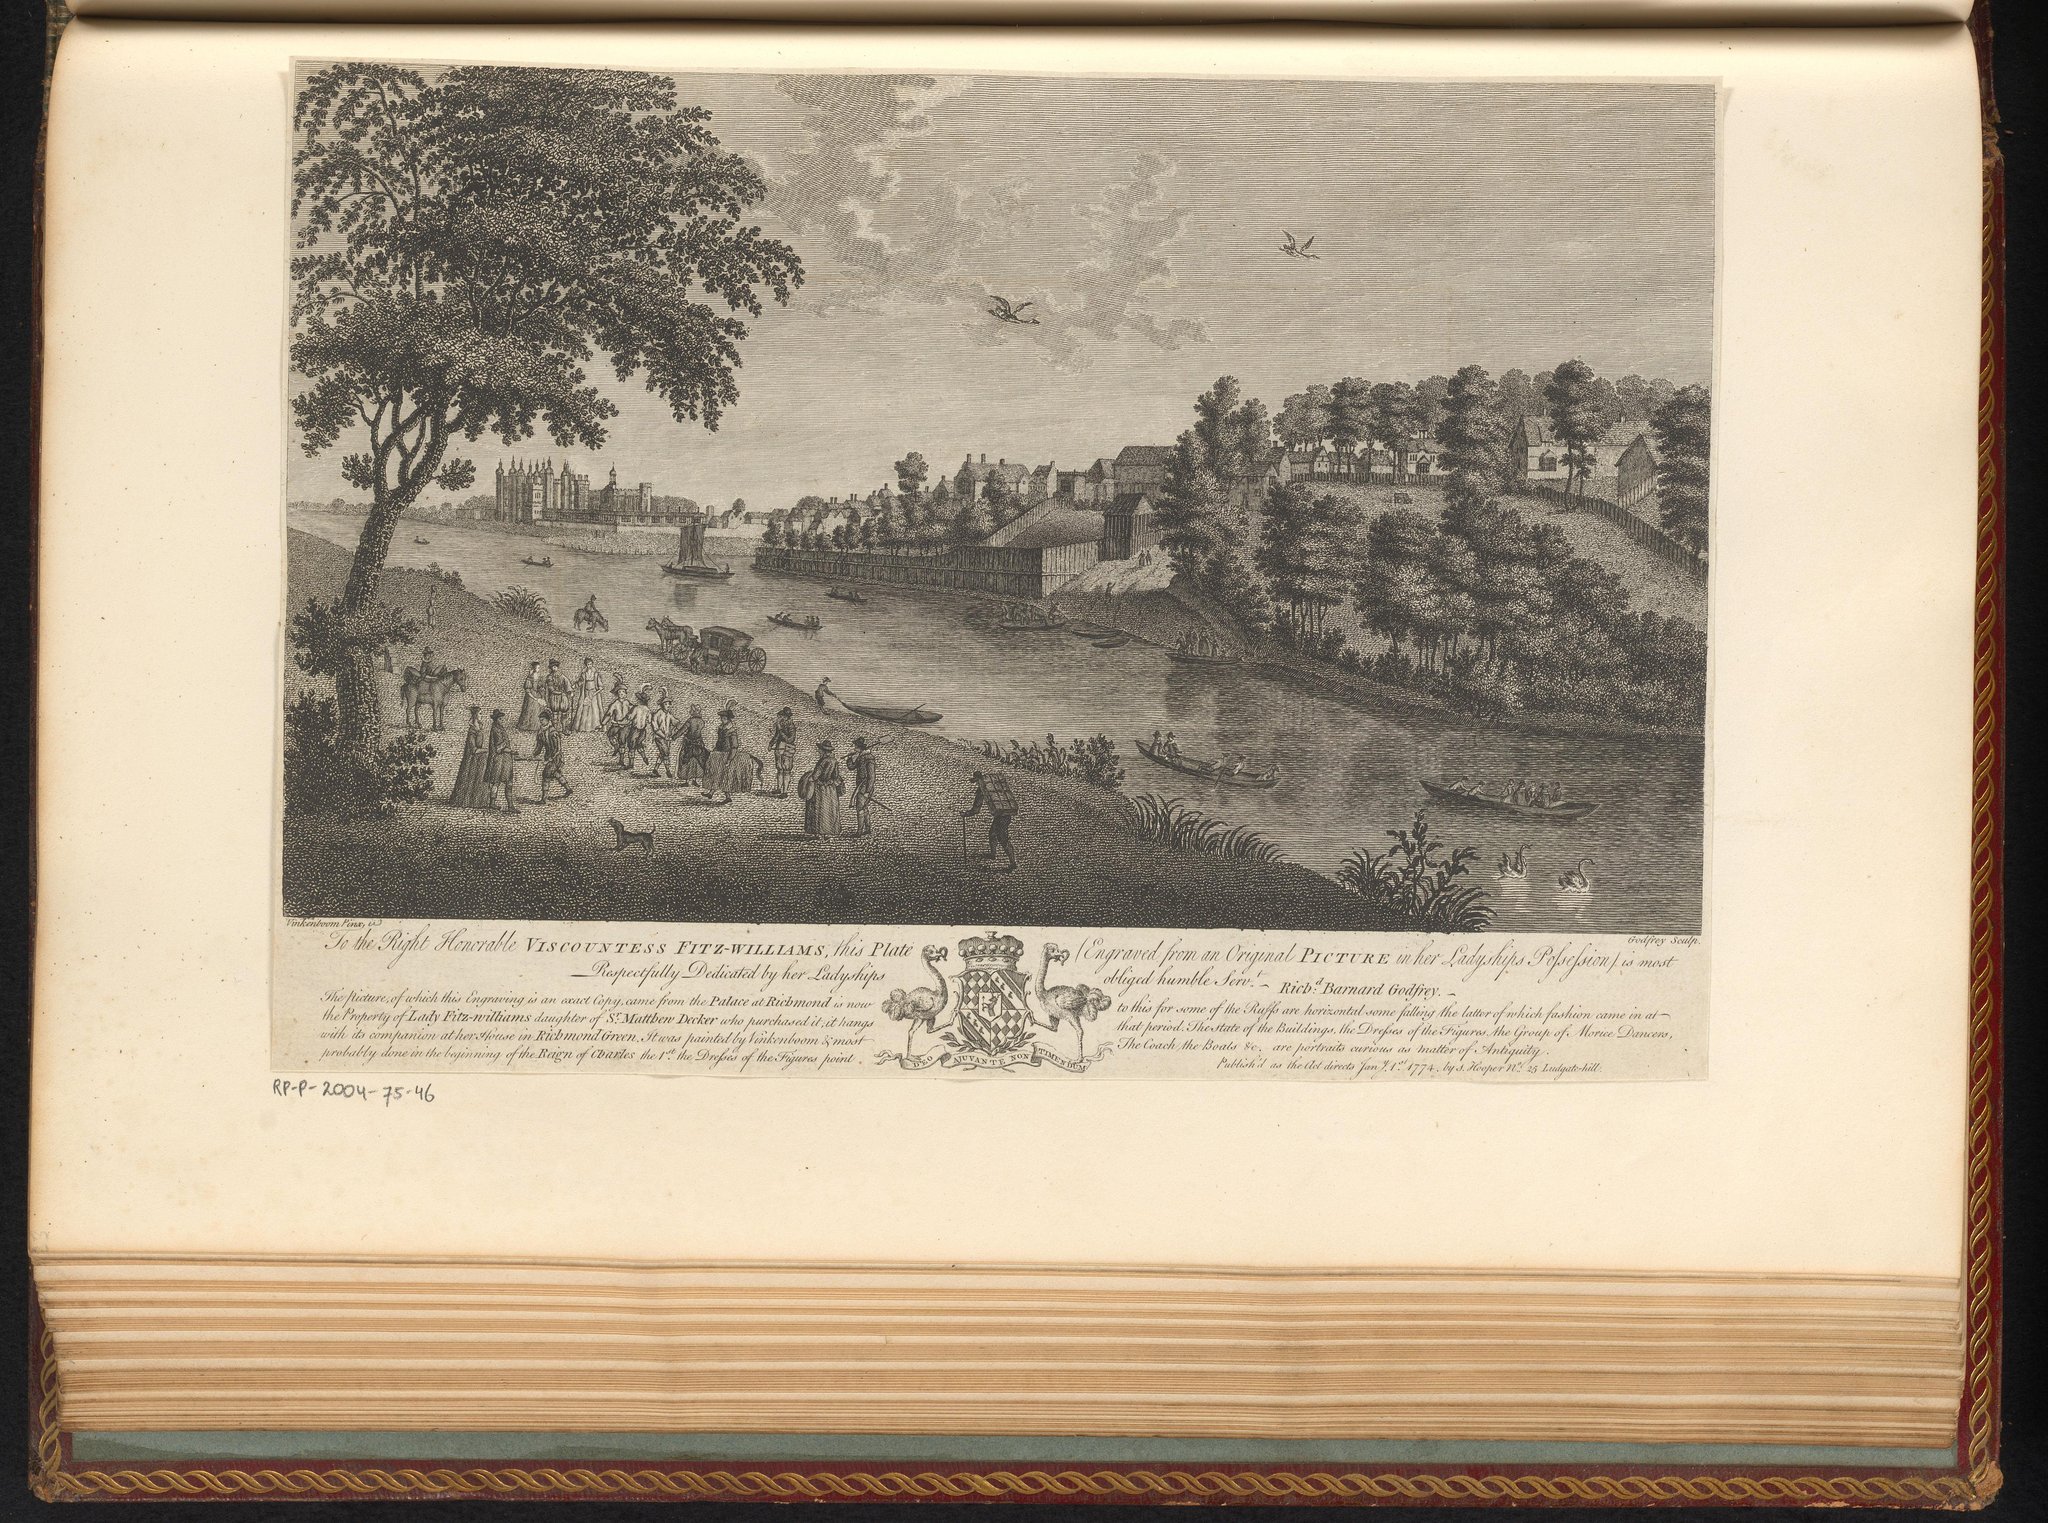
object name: album leaf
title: Landschap met figuren bij een rivier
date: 1774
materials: paper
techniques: engraving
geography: london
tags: river (+ landscape with figures, staffage)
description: De samensteller heeft deze prent in het album geplakt als illustratie bij: Pilkington, Matthew en Johann Heinrich Füssli. A dictionary of painters, from the revival of the art to the present period. 4 dln. Londen: John Crowder, 1805, dl. 4, p. 625.